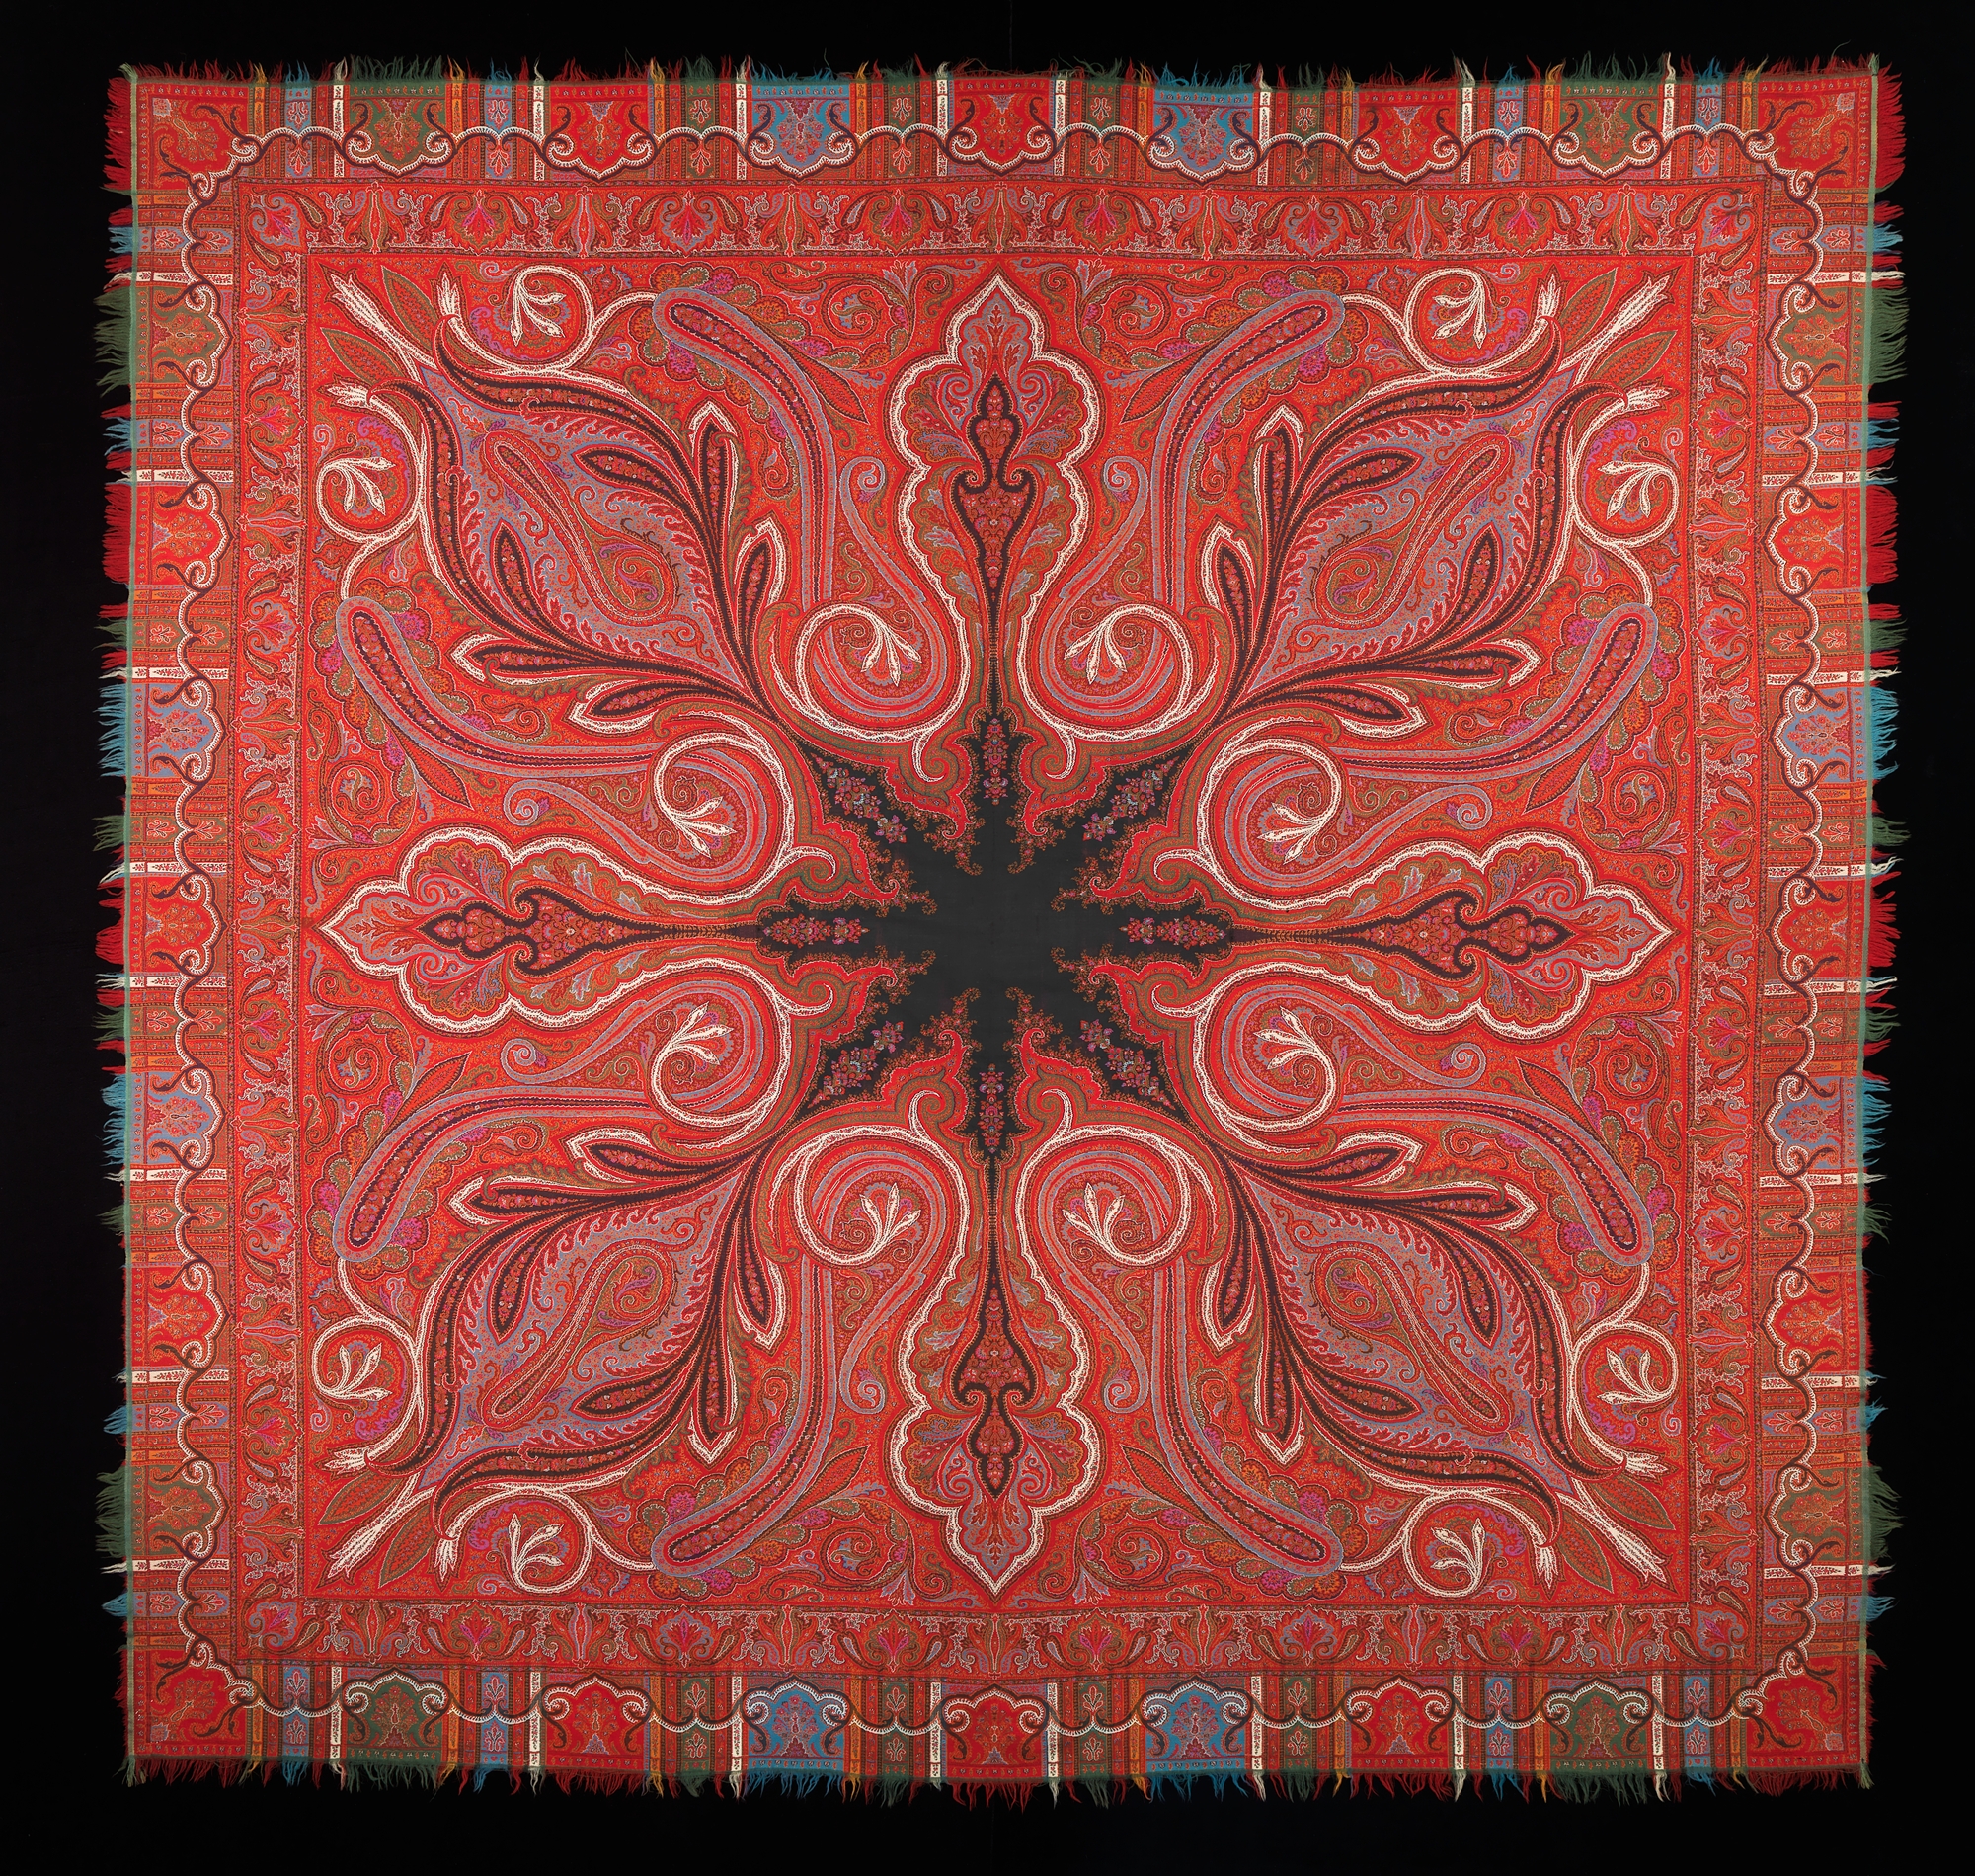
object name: shawl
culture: scottish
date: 1870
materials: wool